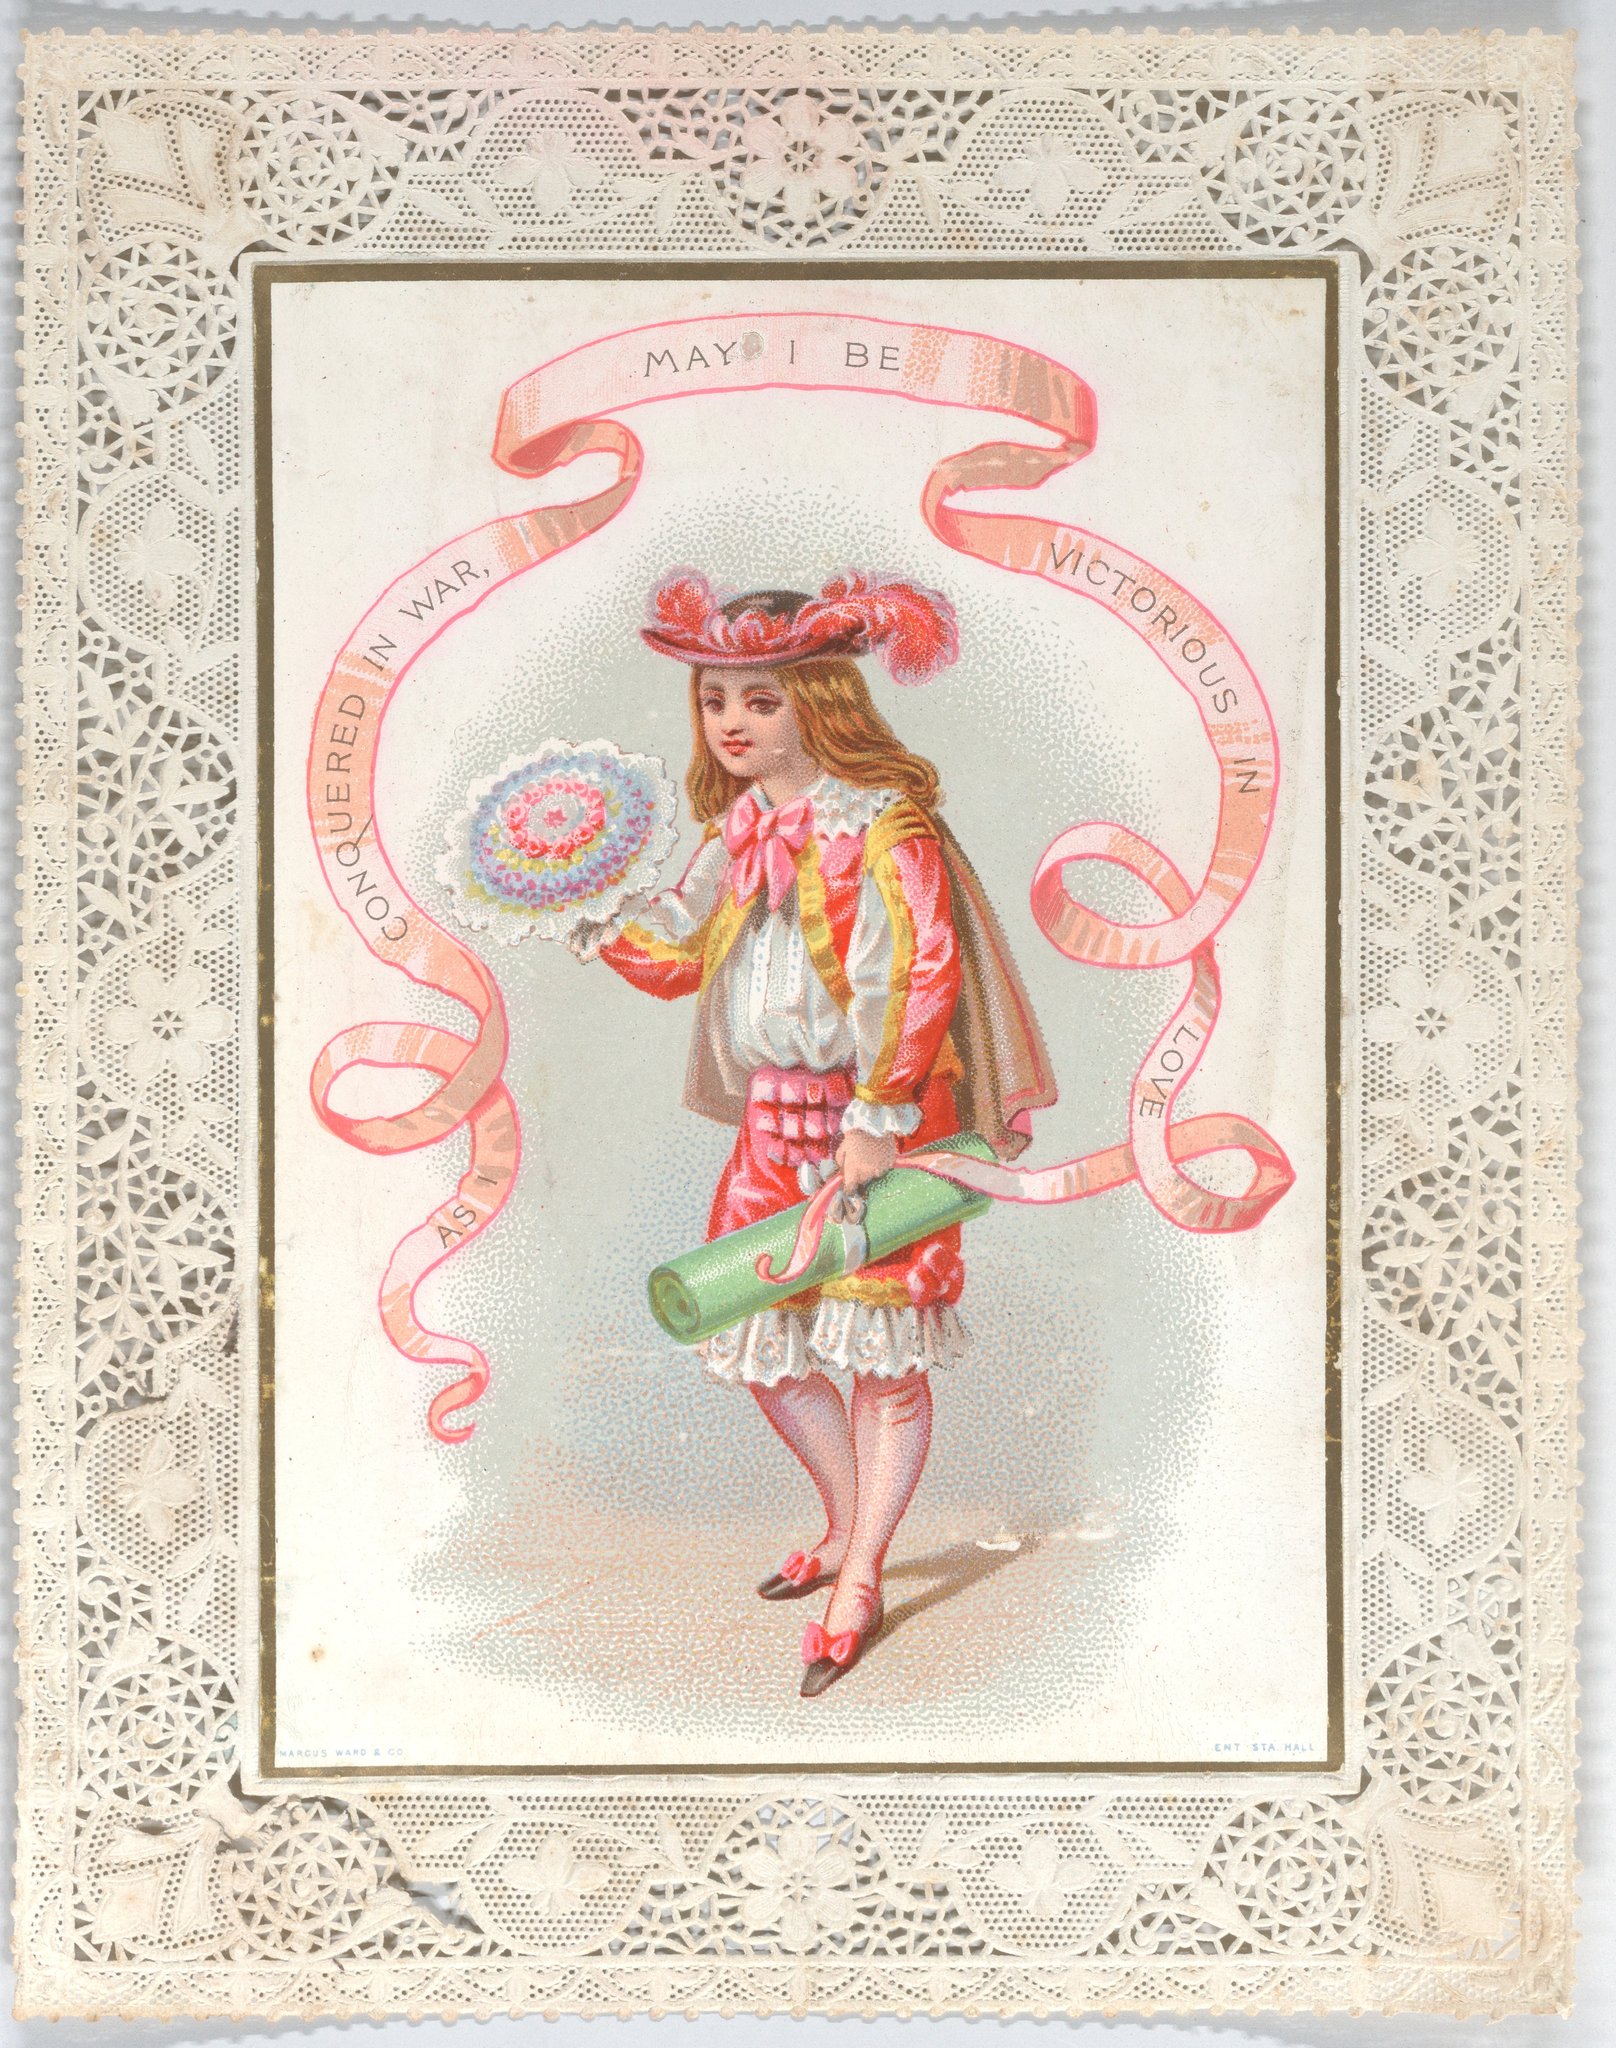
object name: valentine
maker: Anonymous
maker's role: artist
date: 1880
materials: gold, lace, paper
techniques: chromolithography, lithograph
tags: men